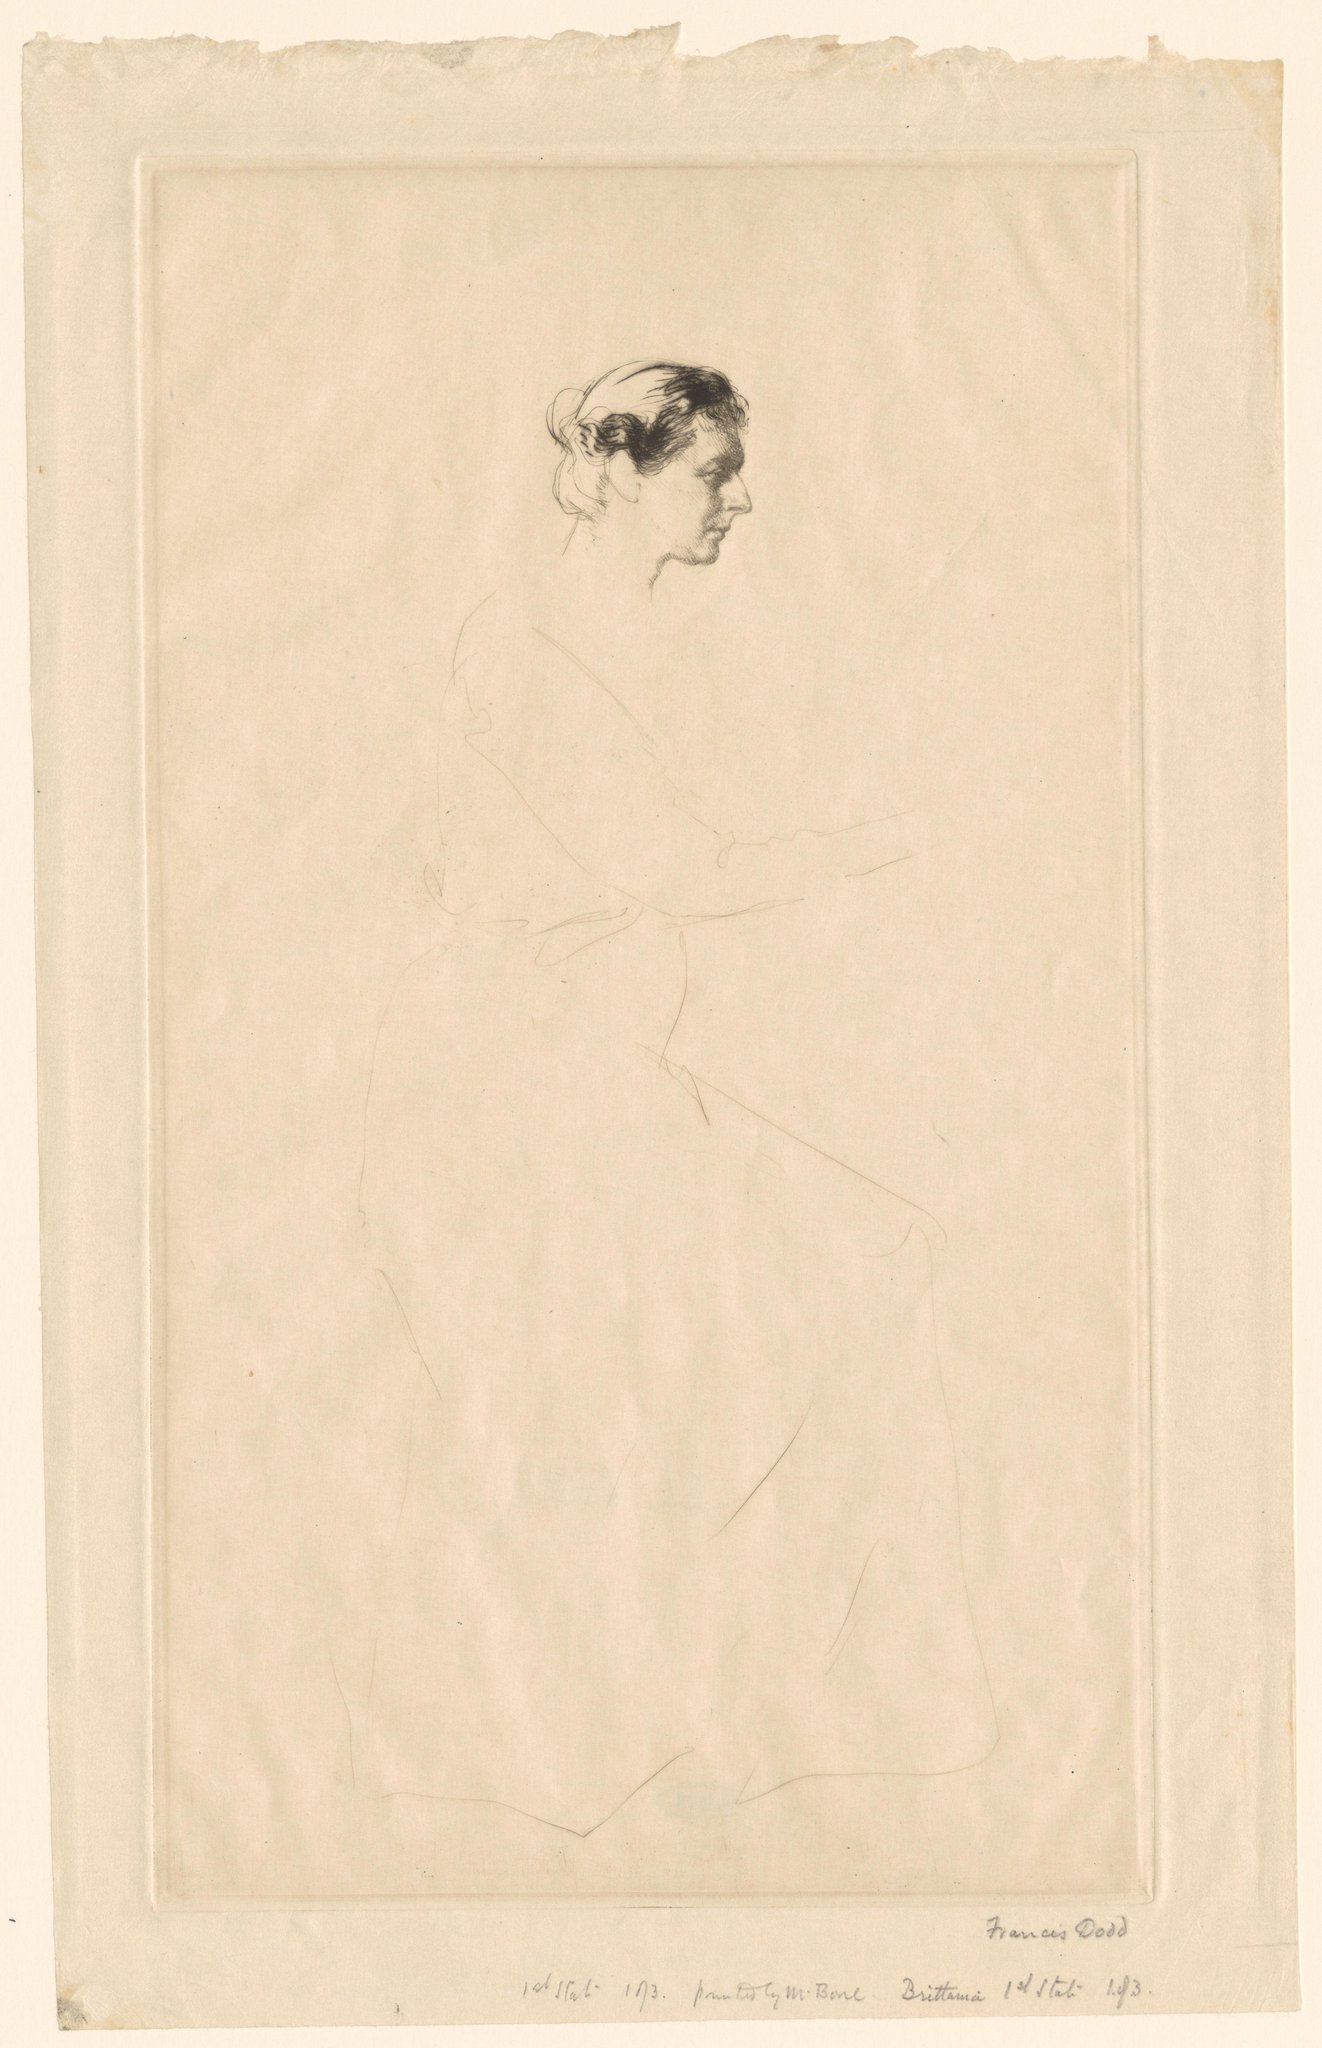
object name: print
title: Portret van een onbekende vrouw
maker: francis dodd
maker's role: print maker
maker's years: 1874-1949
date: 1884-1936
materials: paper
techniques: drypoint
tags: head (human)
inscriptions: collector's mark: Lugt 2228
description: De vrouw is zittend afgebeeld, maar alleen het gezicht is gedetailleerd weergegeven.